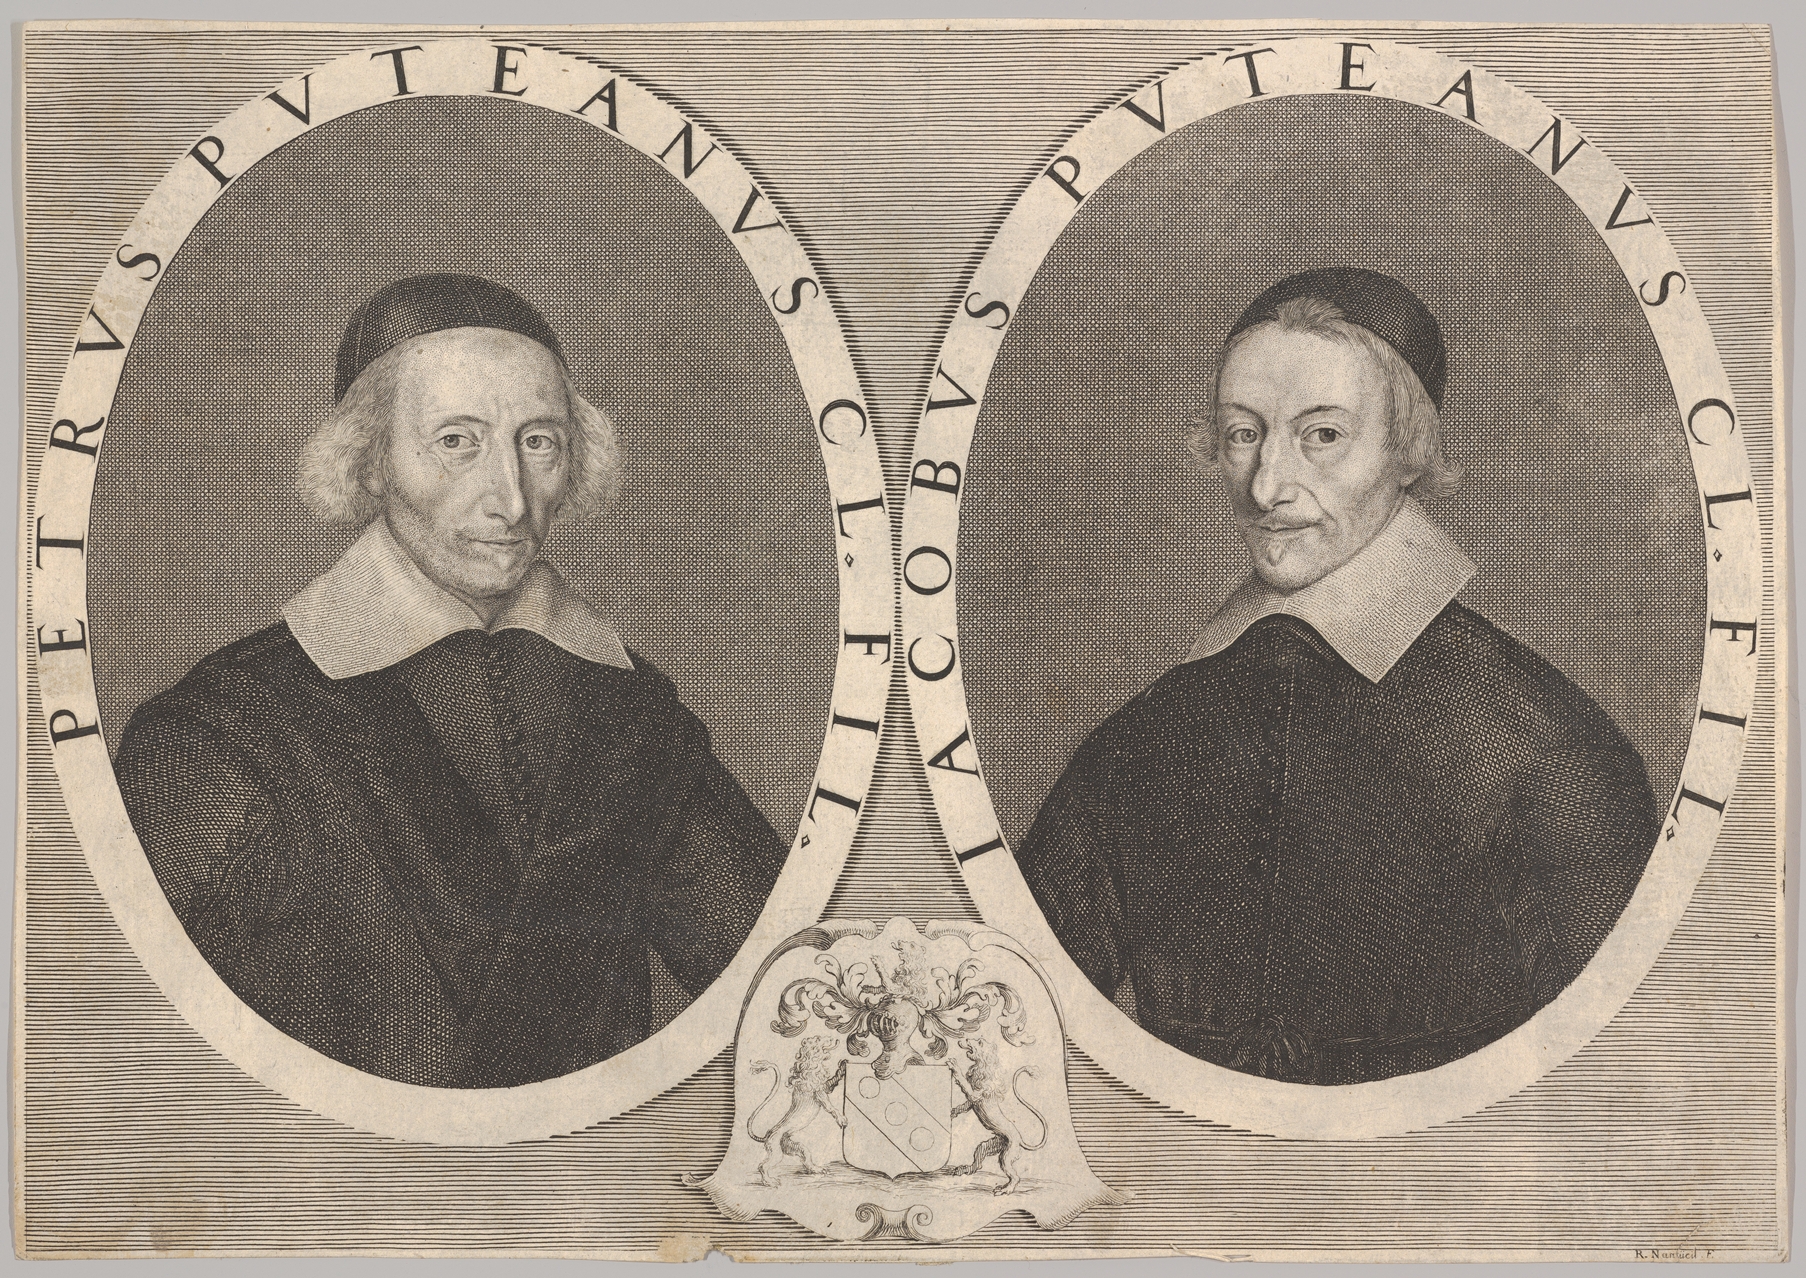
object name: print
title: Double Portrait of Pierre and Jacques Dupuy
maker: robert nanteuil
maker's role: artist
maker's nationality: french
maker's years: 1623-1678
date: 1648-1649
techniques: engraving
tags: men,portraits,coat of arms